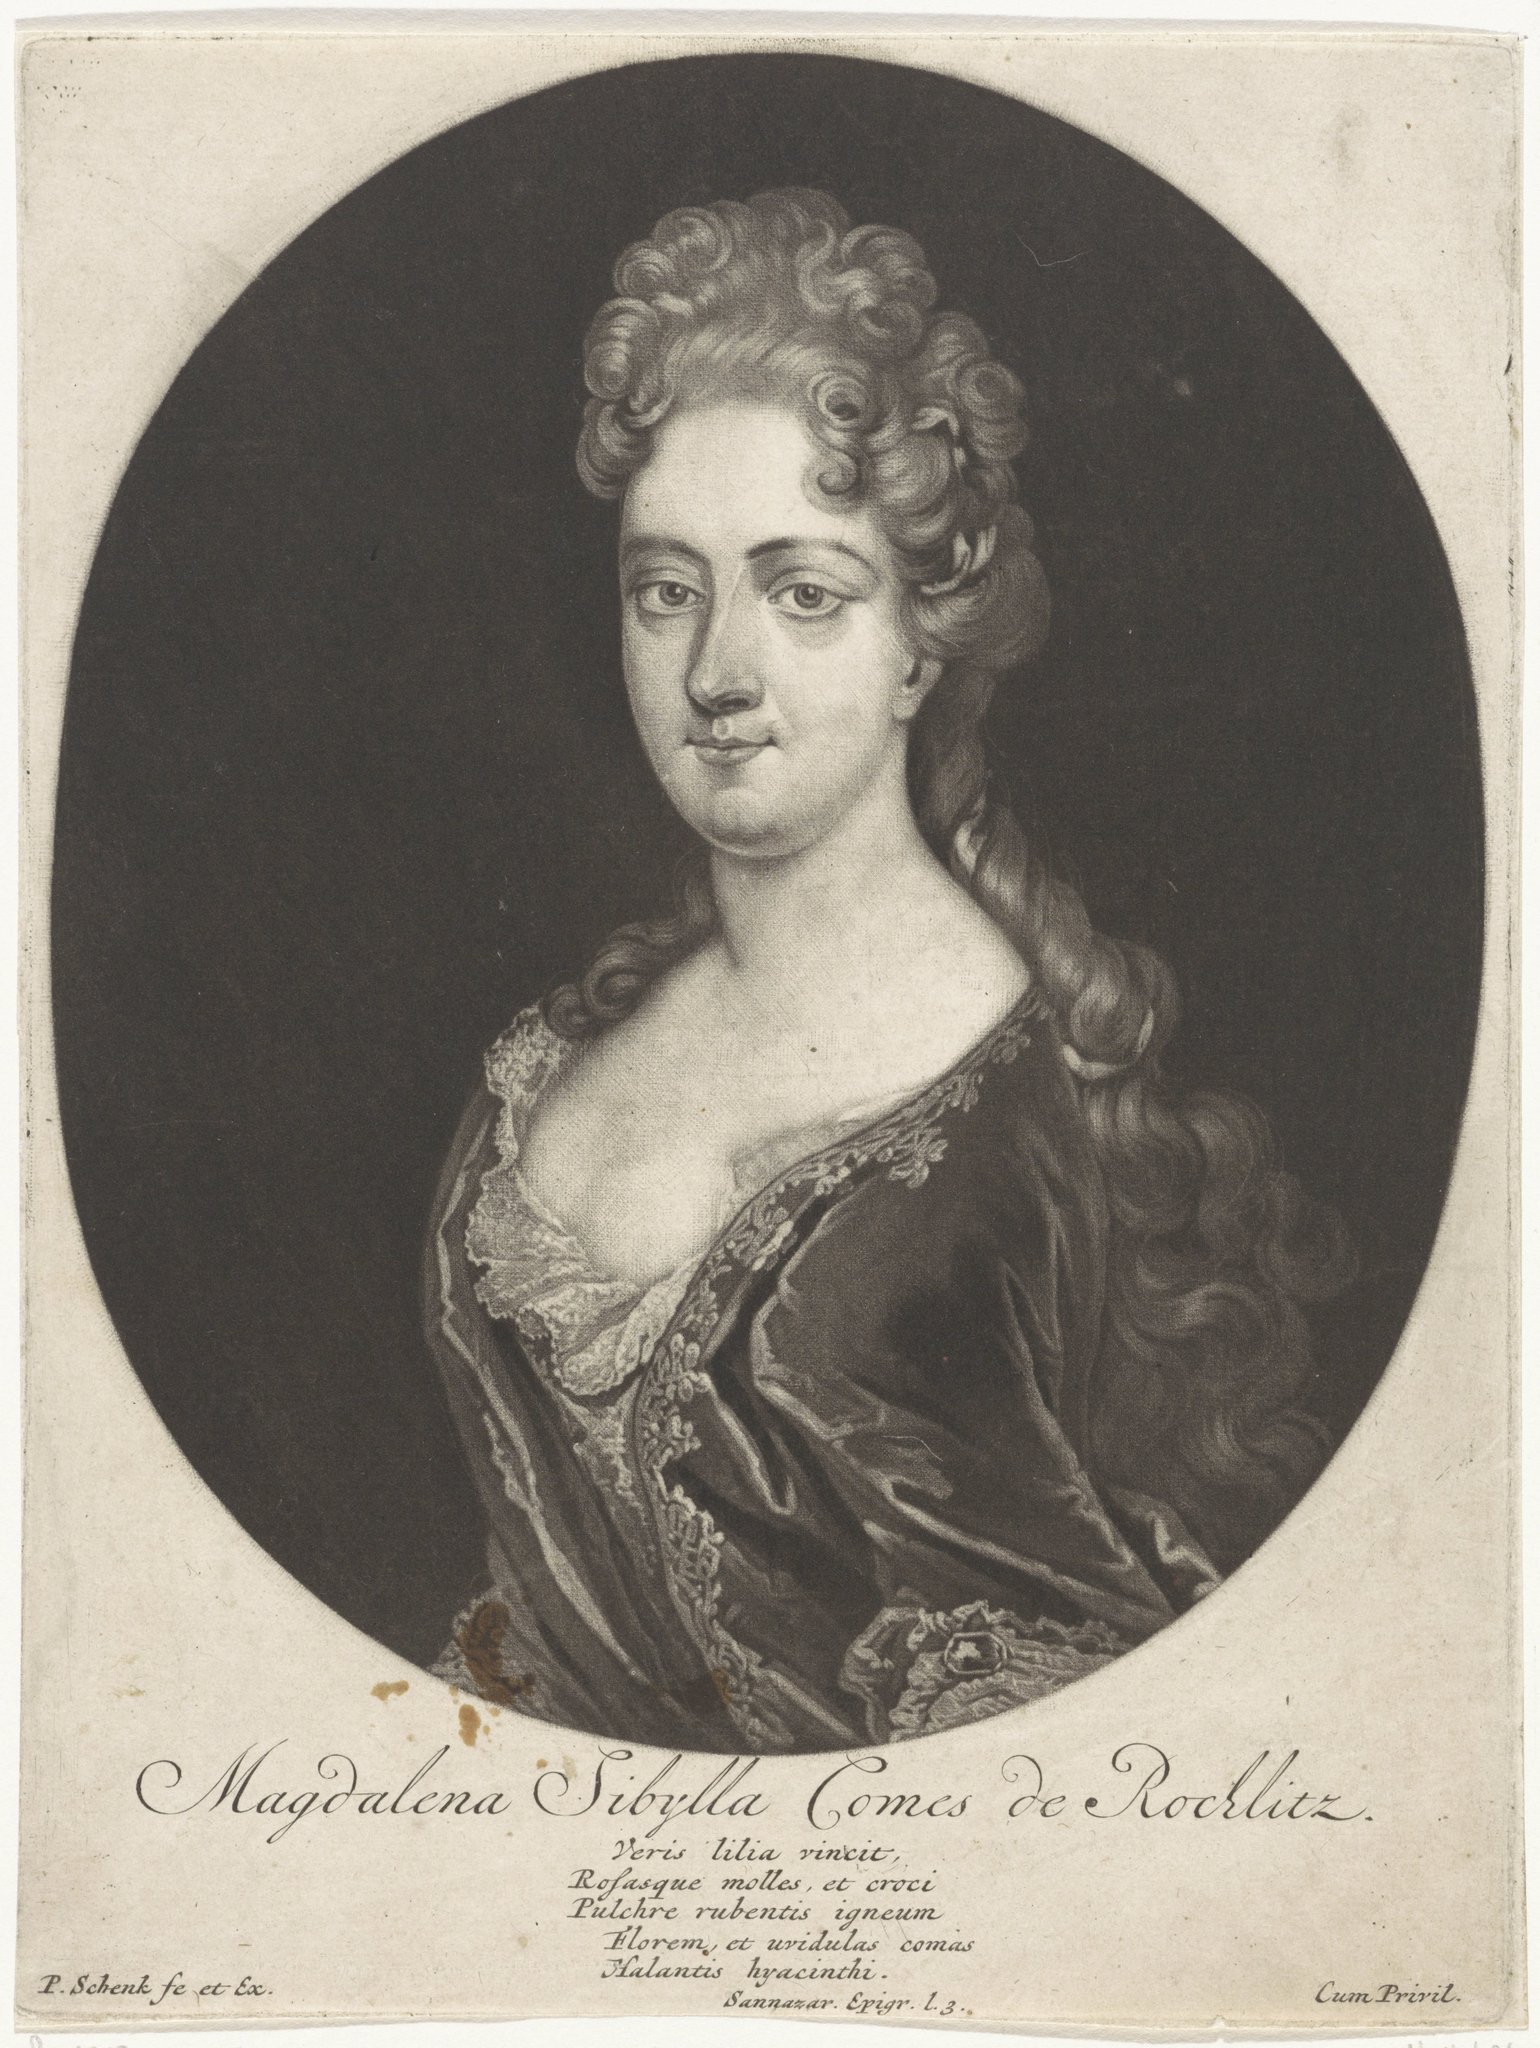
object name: print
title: Portret van Magdalena Sibylla von Neitschütz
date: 1690-1713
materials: paper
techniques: engraving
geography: amsterdam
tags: mistress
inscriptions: collector's mark: Lugt 2228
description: Magdalena Sibylla von Neitschütz, maîtresse van Johan Georg IV keurvorst van Saksen.